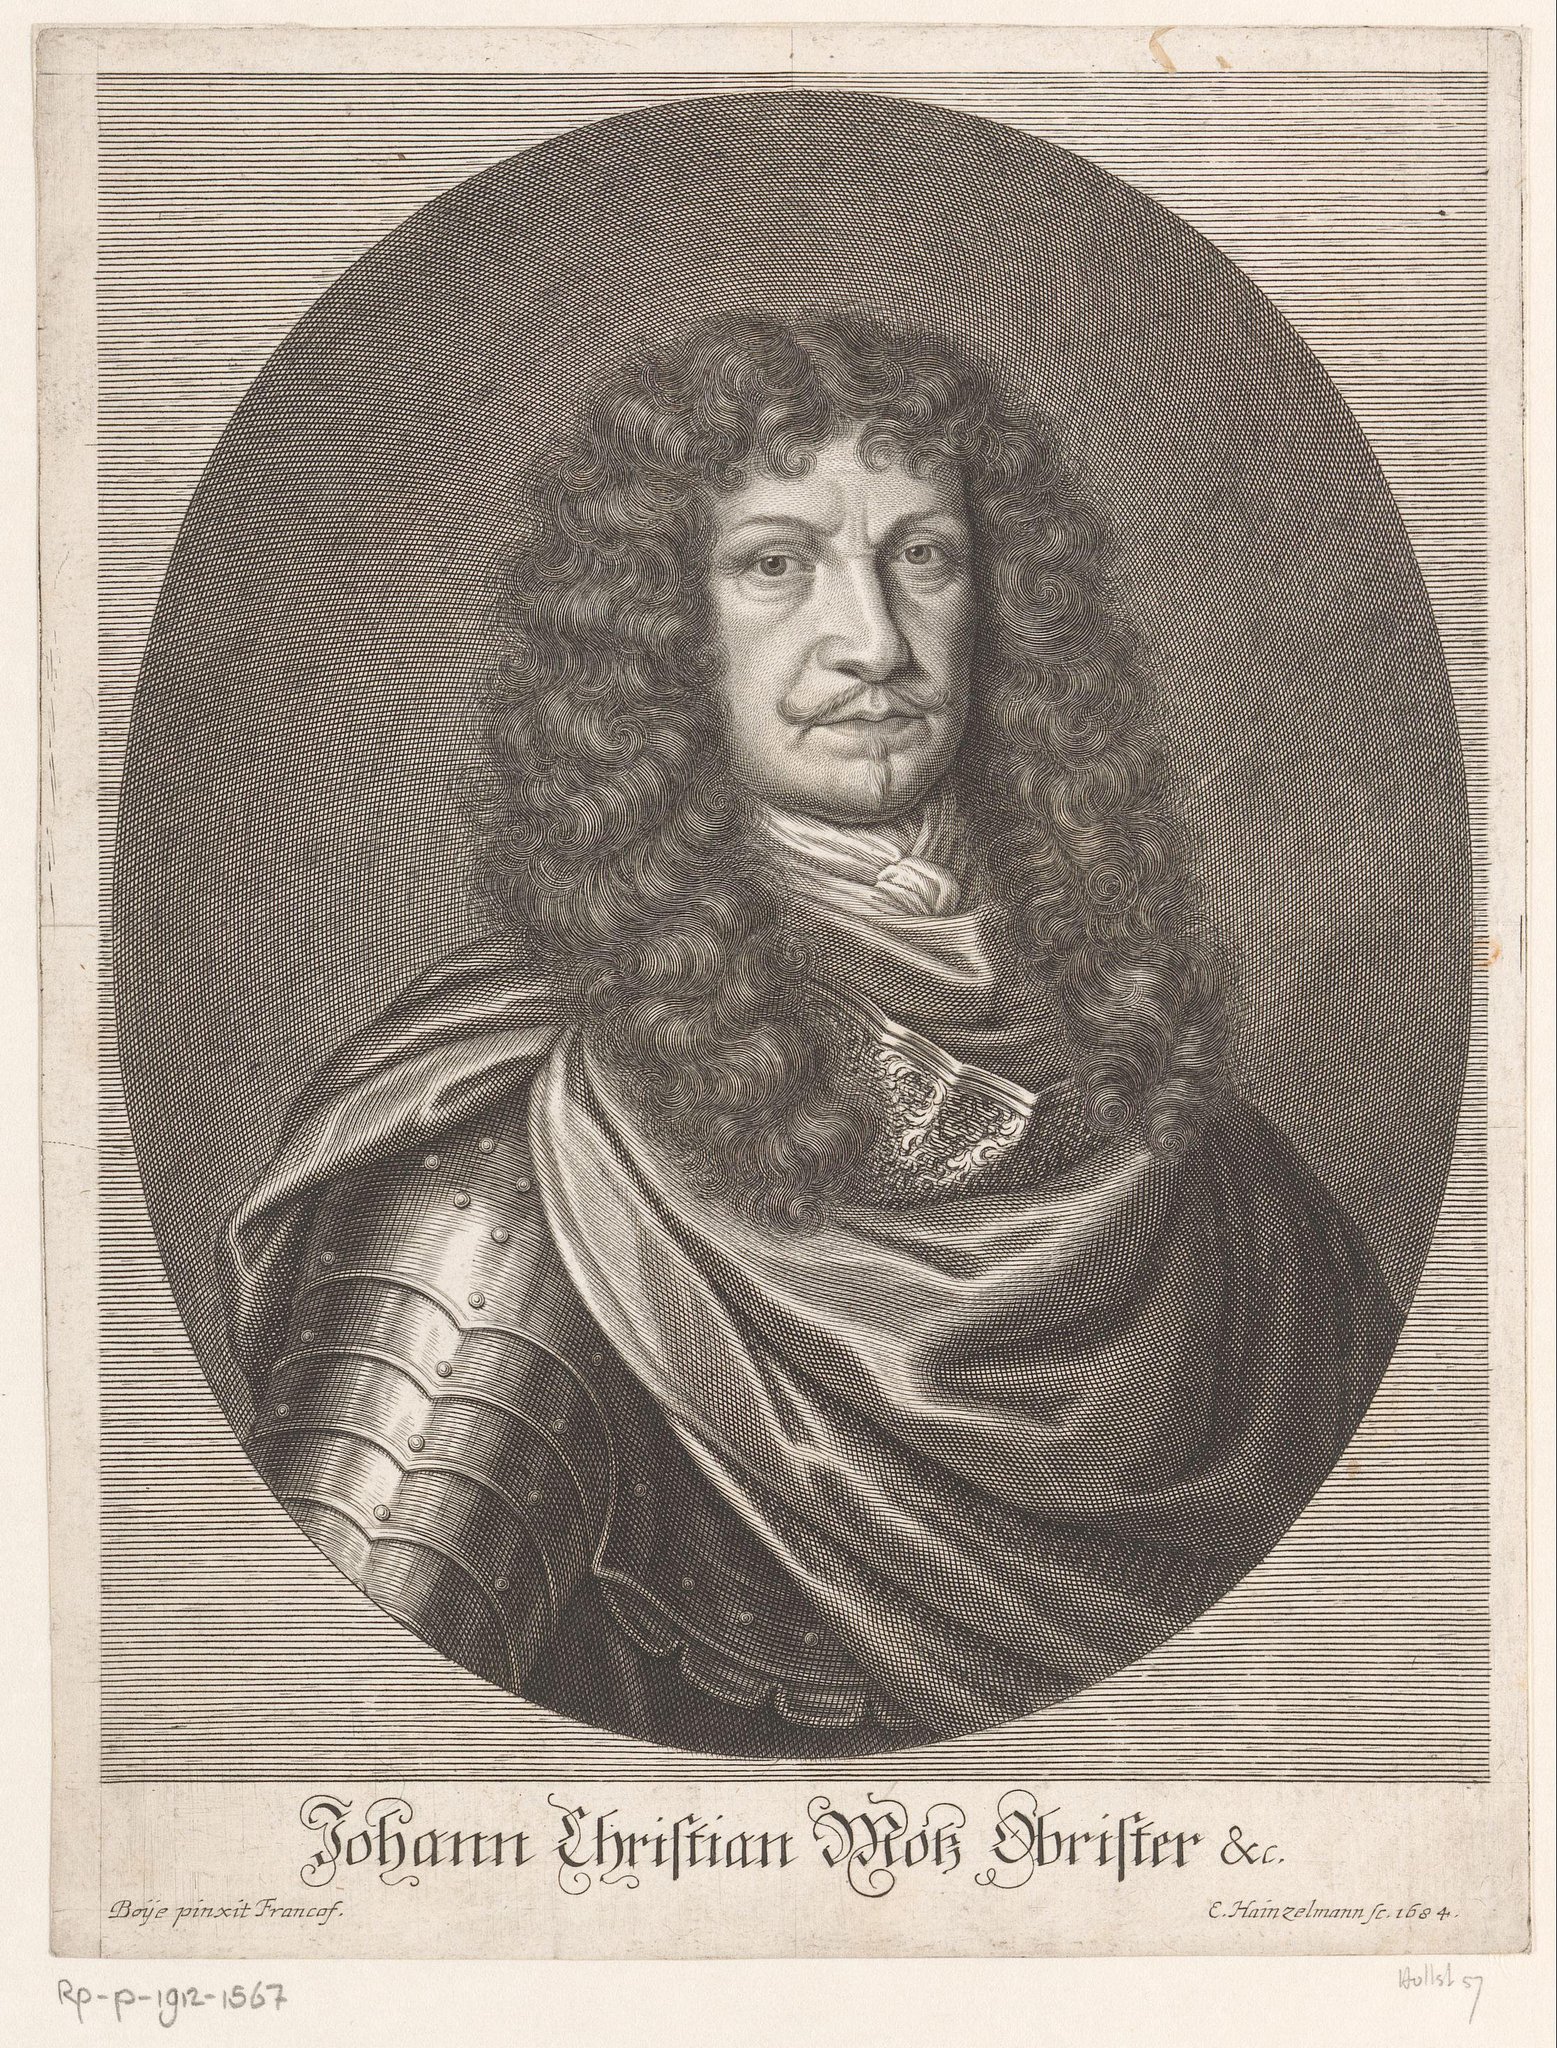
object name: print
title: Portret van Johann Christian Motz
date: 1684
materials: paper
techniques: engraving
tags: commander-in-chief, general, marshal, historical persons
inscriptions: collector's mark: Lugt 2228